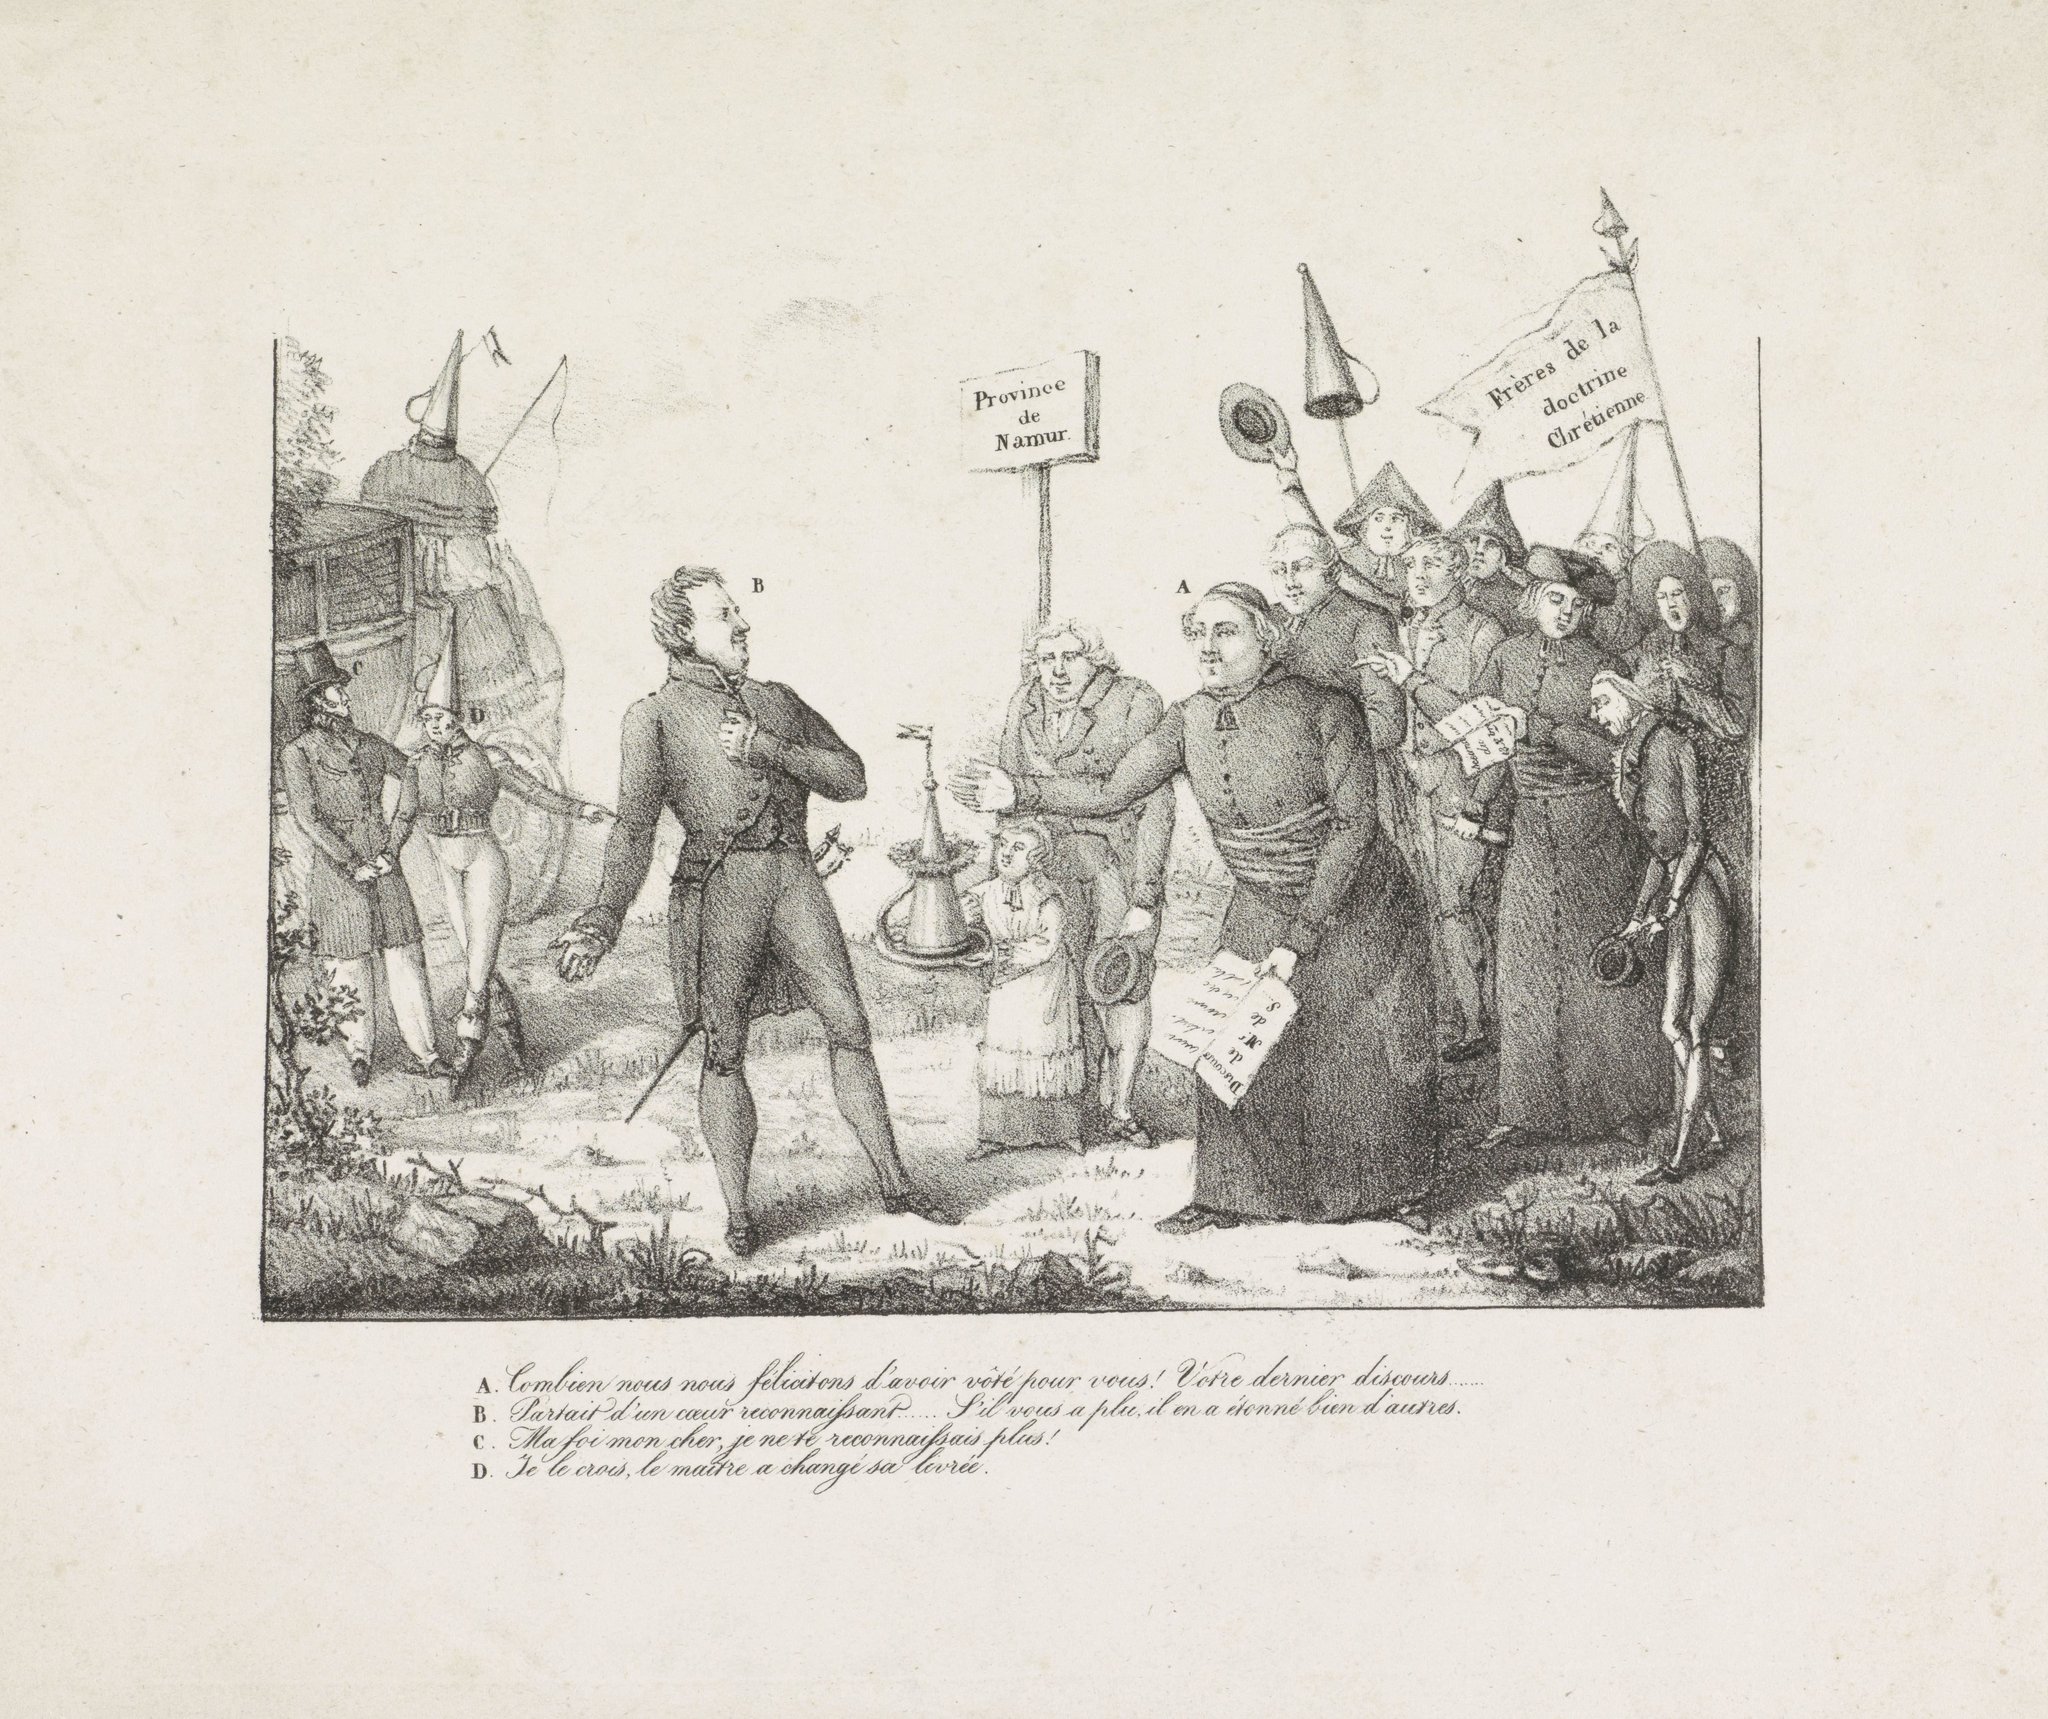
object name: print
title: Spotprent op Baron G.J.A. de Stassart, 1829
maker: Anonymous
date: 1829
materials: paper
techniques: lithograph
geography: netherlands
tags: snuffers, organization, functionaries and dignitaries in roman catholic church; clergy in general, namur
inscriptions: collector's mark: Lugt 2228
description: Spotprent op Goswin Joseph Augustin, baron de Stassart, 1829. Stassart was vroeger zeer liberaal, maar wordt later als vertegenwoordiger in de Tweede Kamer van de provincie Namen hevig klerikaal bij de debatten over het Collegium Philosophicum en maakt zich in 1829 sterk voor de grieven door België ingebracht. Stassart staande bij de grens met de provincie Namen met tegenover zich een groep geestelijken. Hij krijgt van een koorknaap een domper aangereikt. Onderaan de legenda A-D.